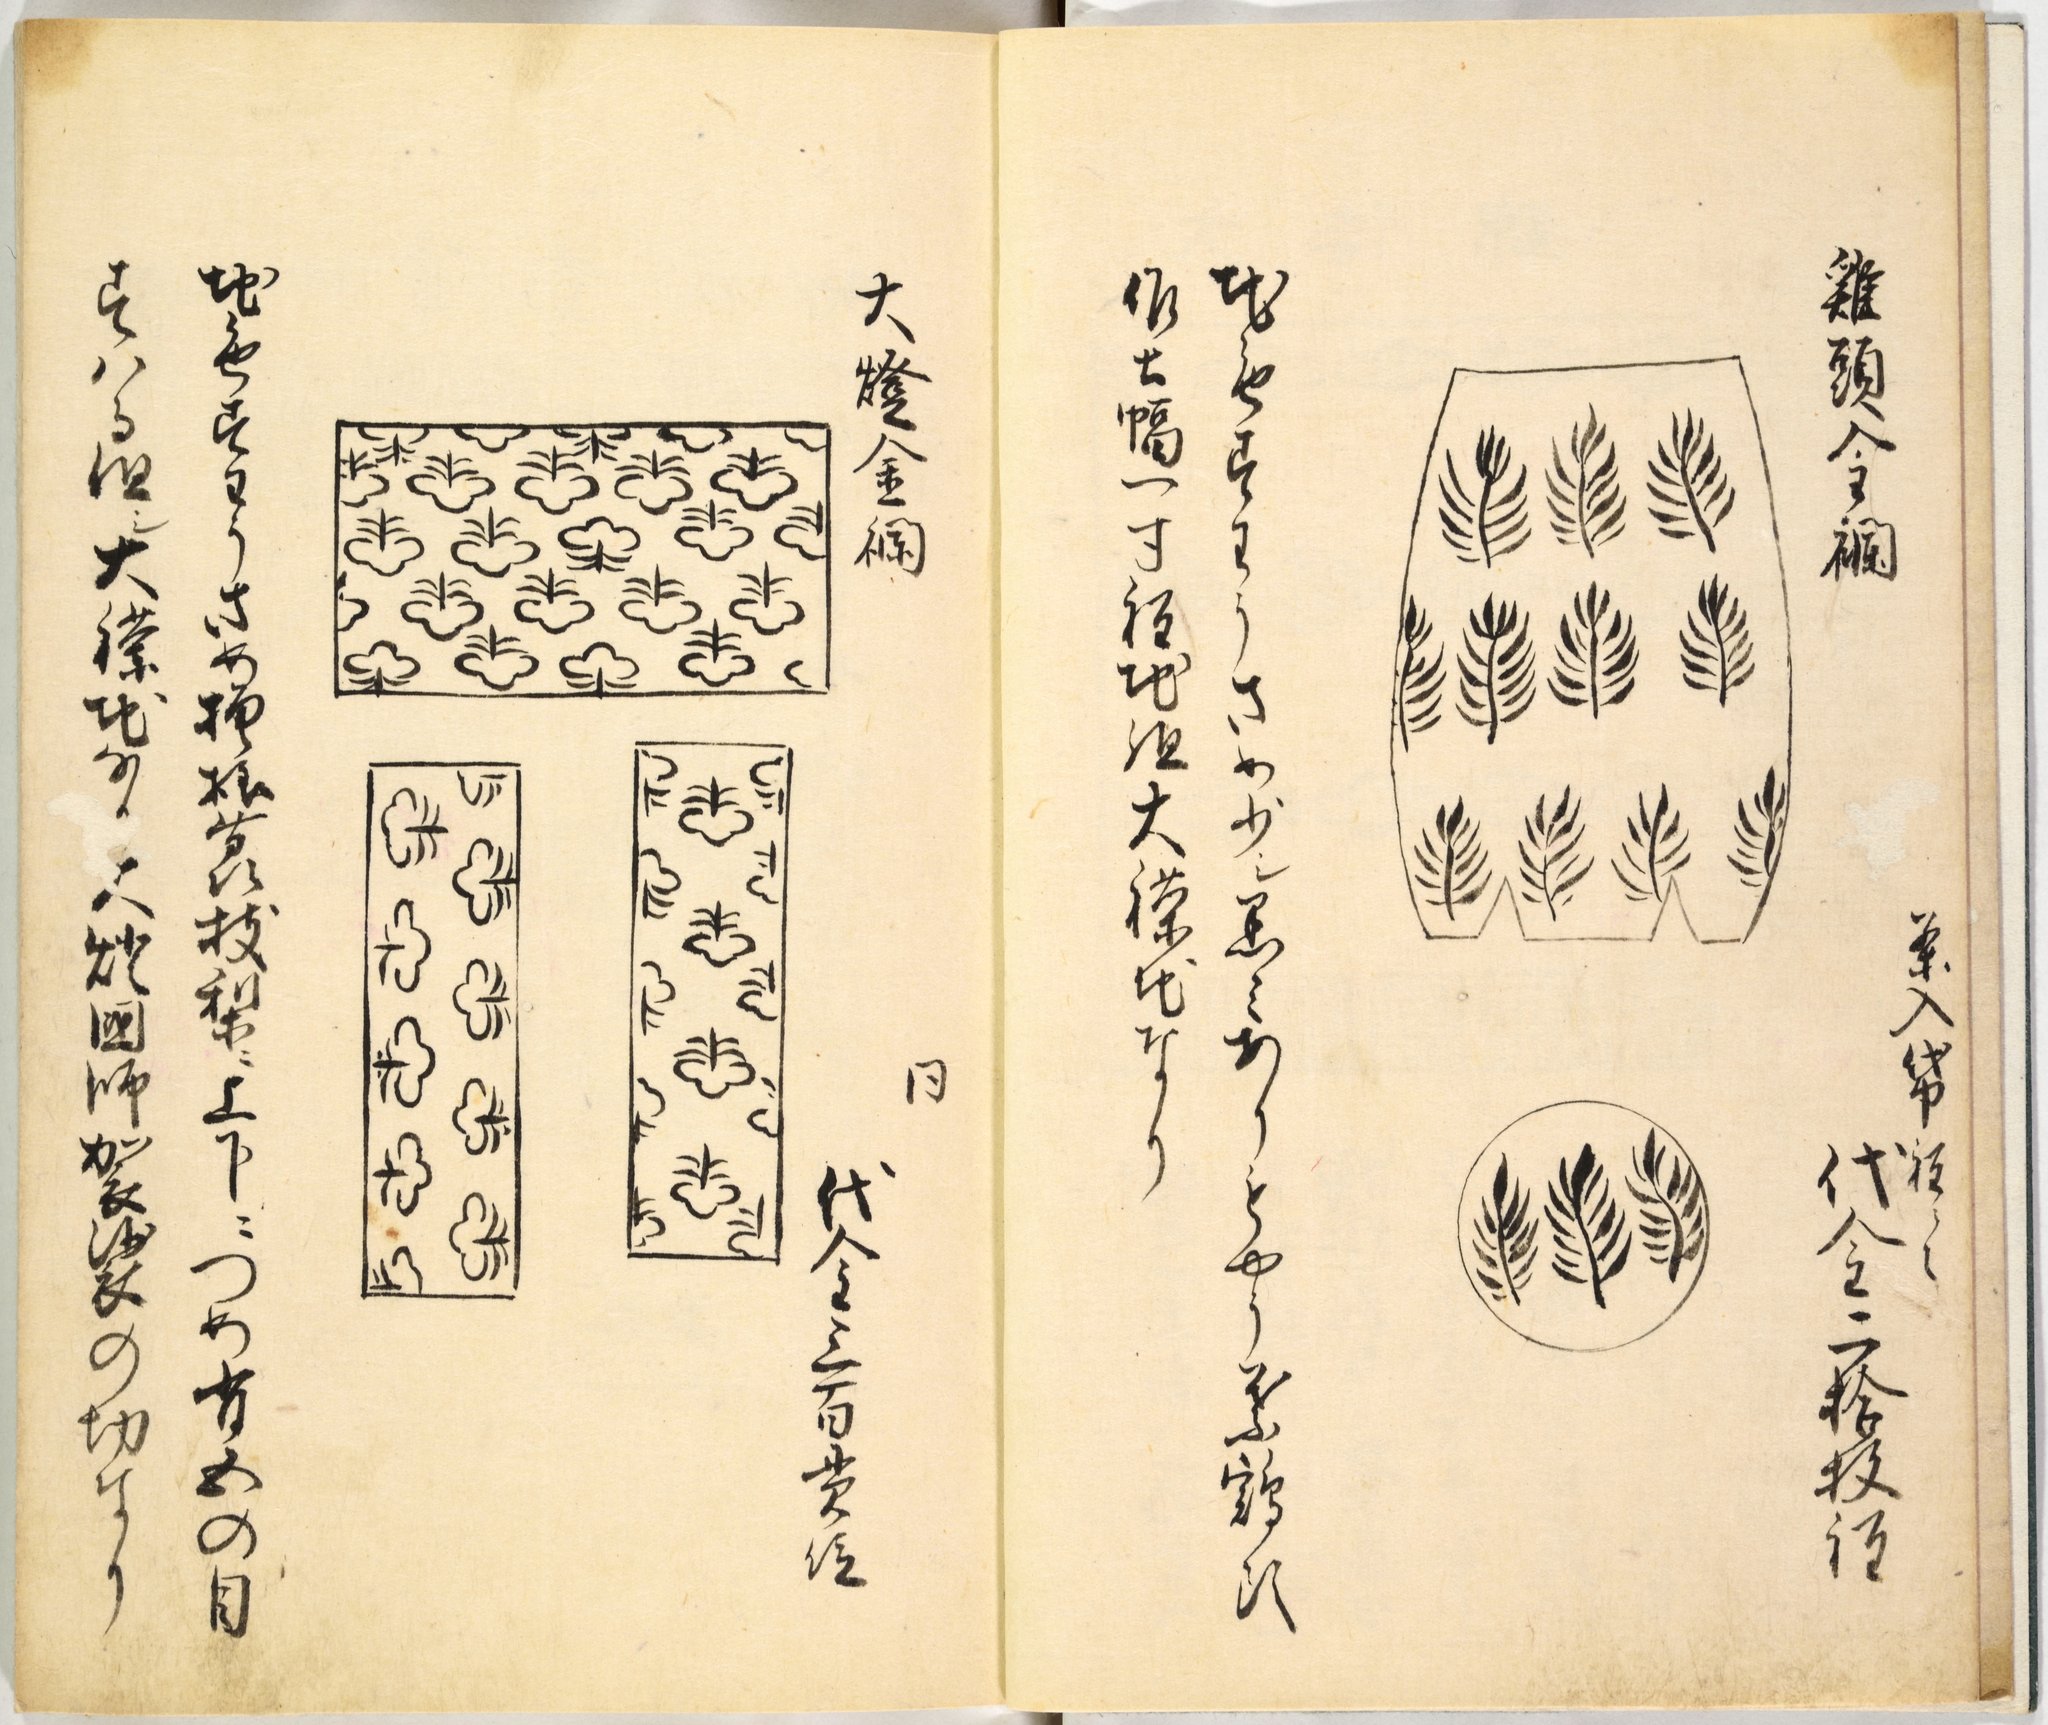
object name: illustrated book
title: Picture Book of Gold Brocades (Kinrandonsu ezu)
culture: japanese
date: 1783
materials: ink, paper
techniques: woodblock print